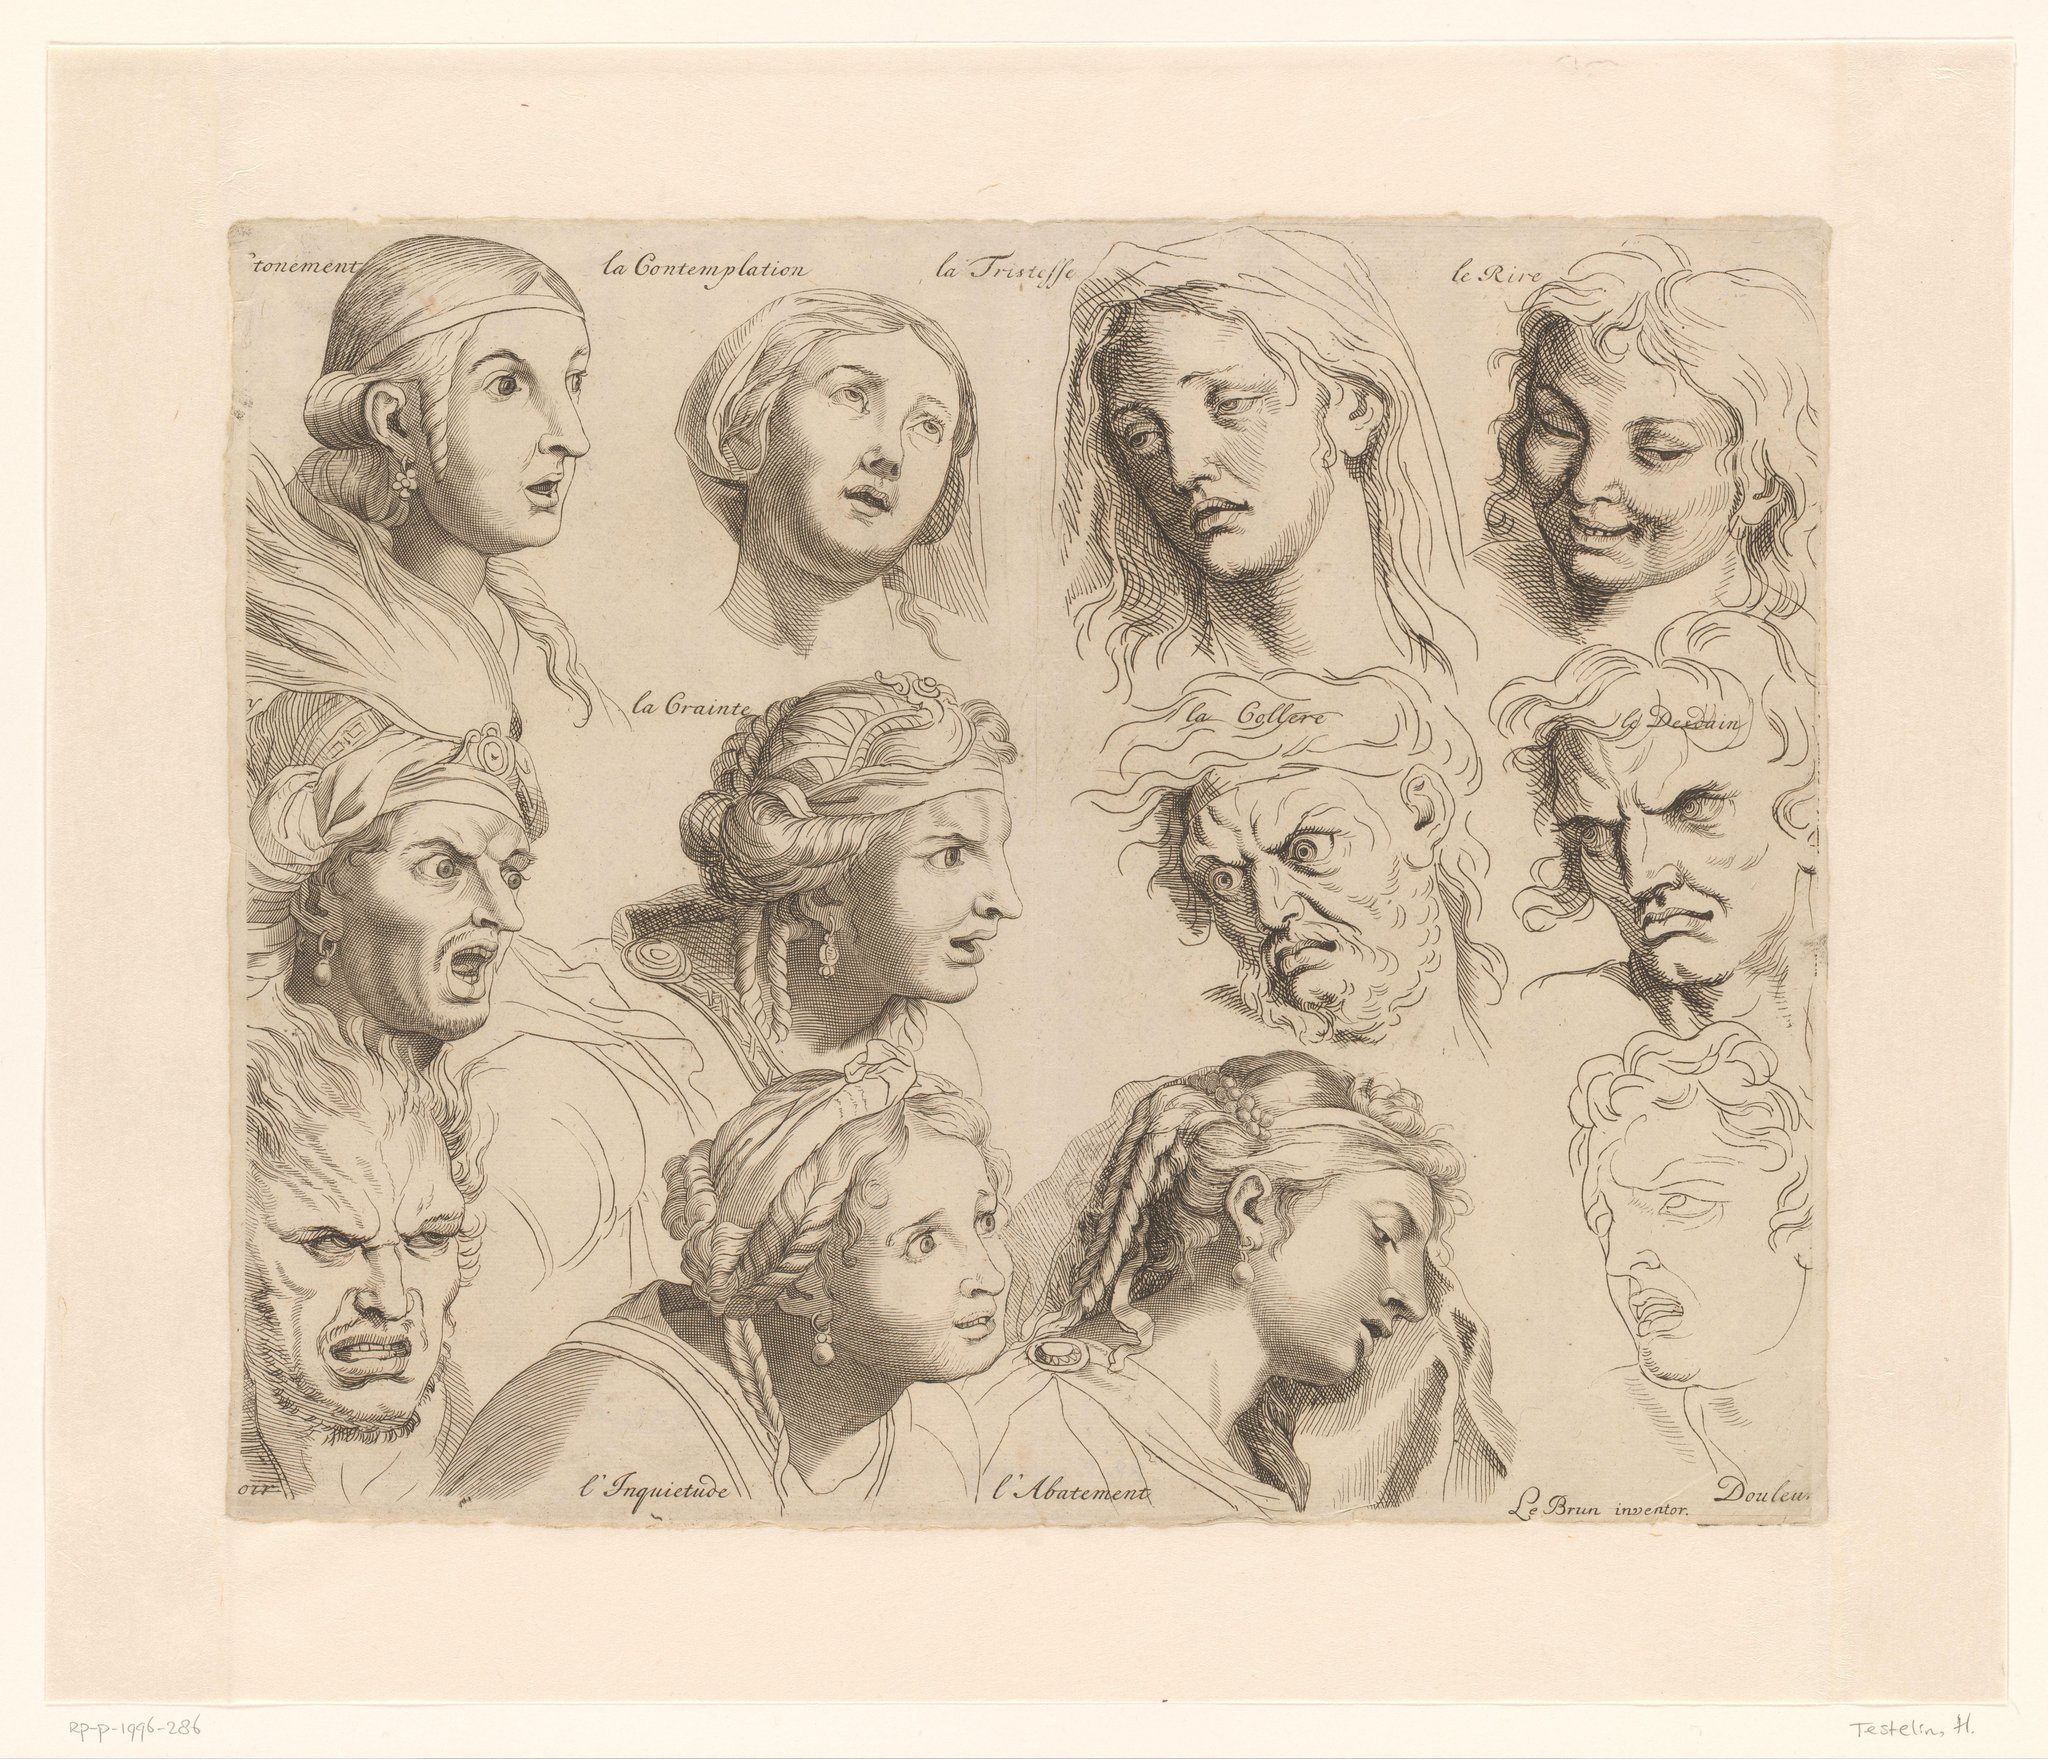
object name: print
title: Twaalf hoofden met verschillende gezichtsuitdrukkingen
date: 1693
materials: paper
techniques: engraving, etching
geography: the hague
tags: head (human), morphology of facial expression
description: Van linksboven naar rechtsonder: Etonement, la Contemplation, la Tristesse, le Rire, [l'Efroy], la Crainte, la Collere, le Desdain, [le Desespoir], l'Inquietude, l'Abatement, Douleur.